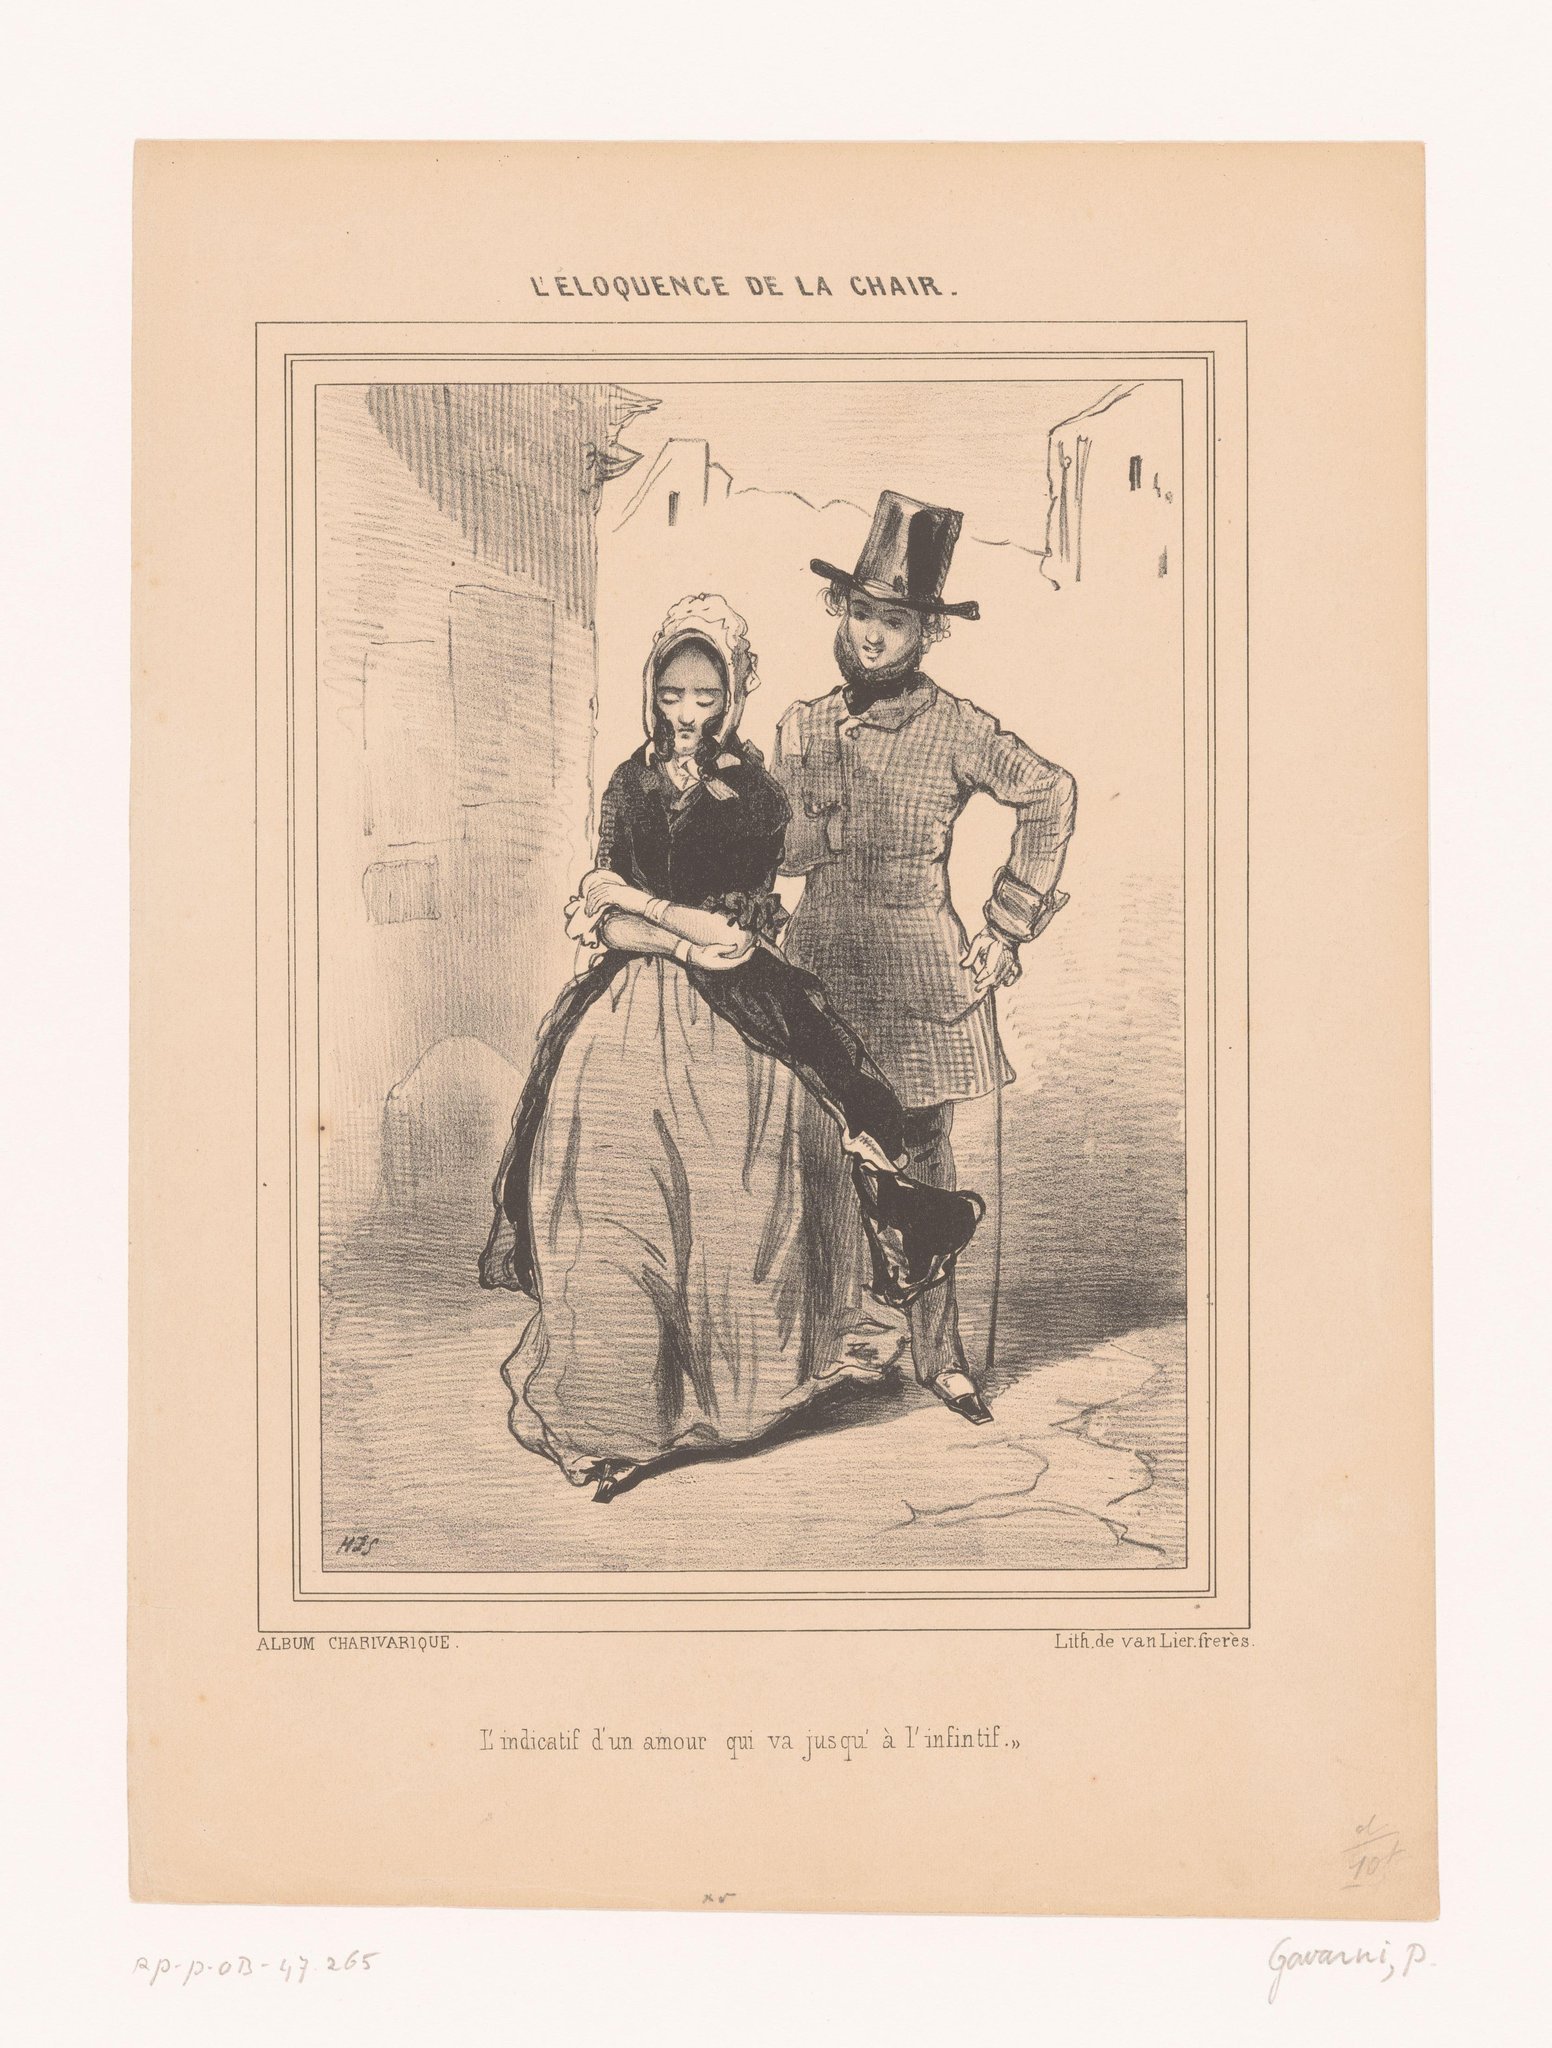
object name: cartoon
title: Welsprekendheid van het vlees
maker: paul gavarni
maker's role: draughtsman, print maker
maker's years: 1804-1866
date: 1843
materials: paper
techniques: lithograph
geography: paris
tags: woman in flight (one-sided courting), walking - aa - female human figure, street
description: Prent gebruikt voor: Le Charivari, 4 oktober 1843.